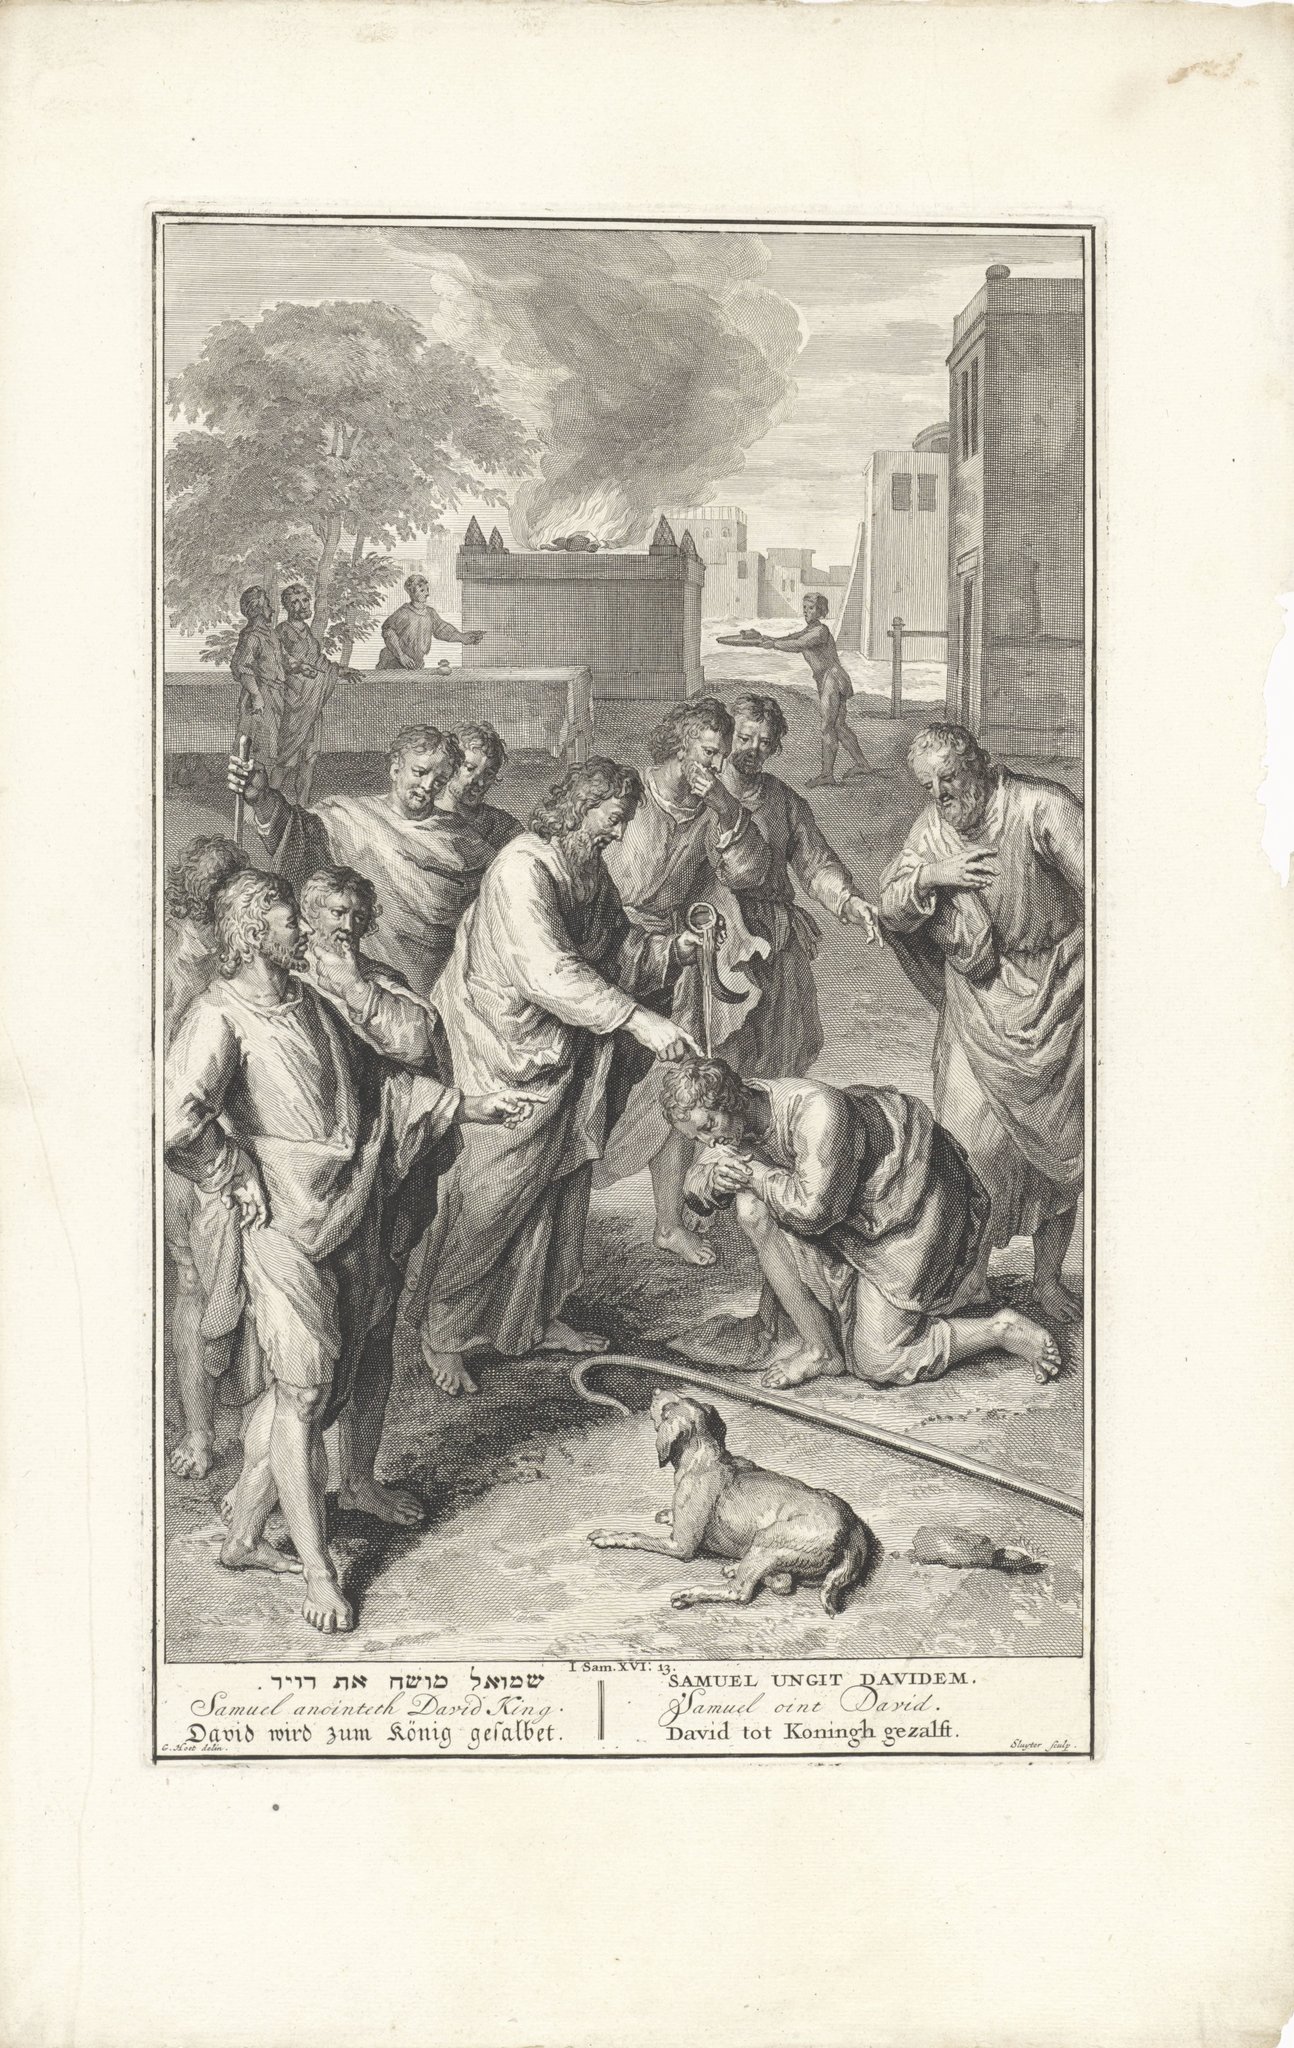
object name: book illustration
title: David tot koning gezalfd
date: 1705-1720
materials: paper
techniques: engraving, etching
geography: amsterdam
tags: samuel anointing david in the presence of his father jesse and his brothers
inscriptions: collector's mark: Lugt 2228, collector's mark: ‘Utrechts Fundatie huijs’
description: Prent oorspronkelijk bedoeld voor: Figures de la Bible. Amsterdam: Bernard Picart, 1720. Prent ook gebruikt in: Taferelen der voornaamste geschiedenissen van het Oude en Nieuwe Testament (...) door de vermaarde kunstenaars Hoet, Houbraken, en Picart getekent (...) en met beschrijvingen uitgebreid. Den Haag: Pieter de Hondt, 1728.